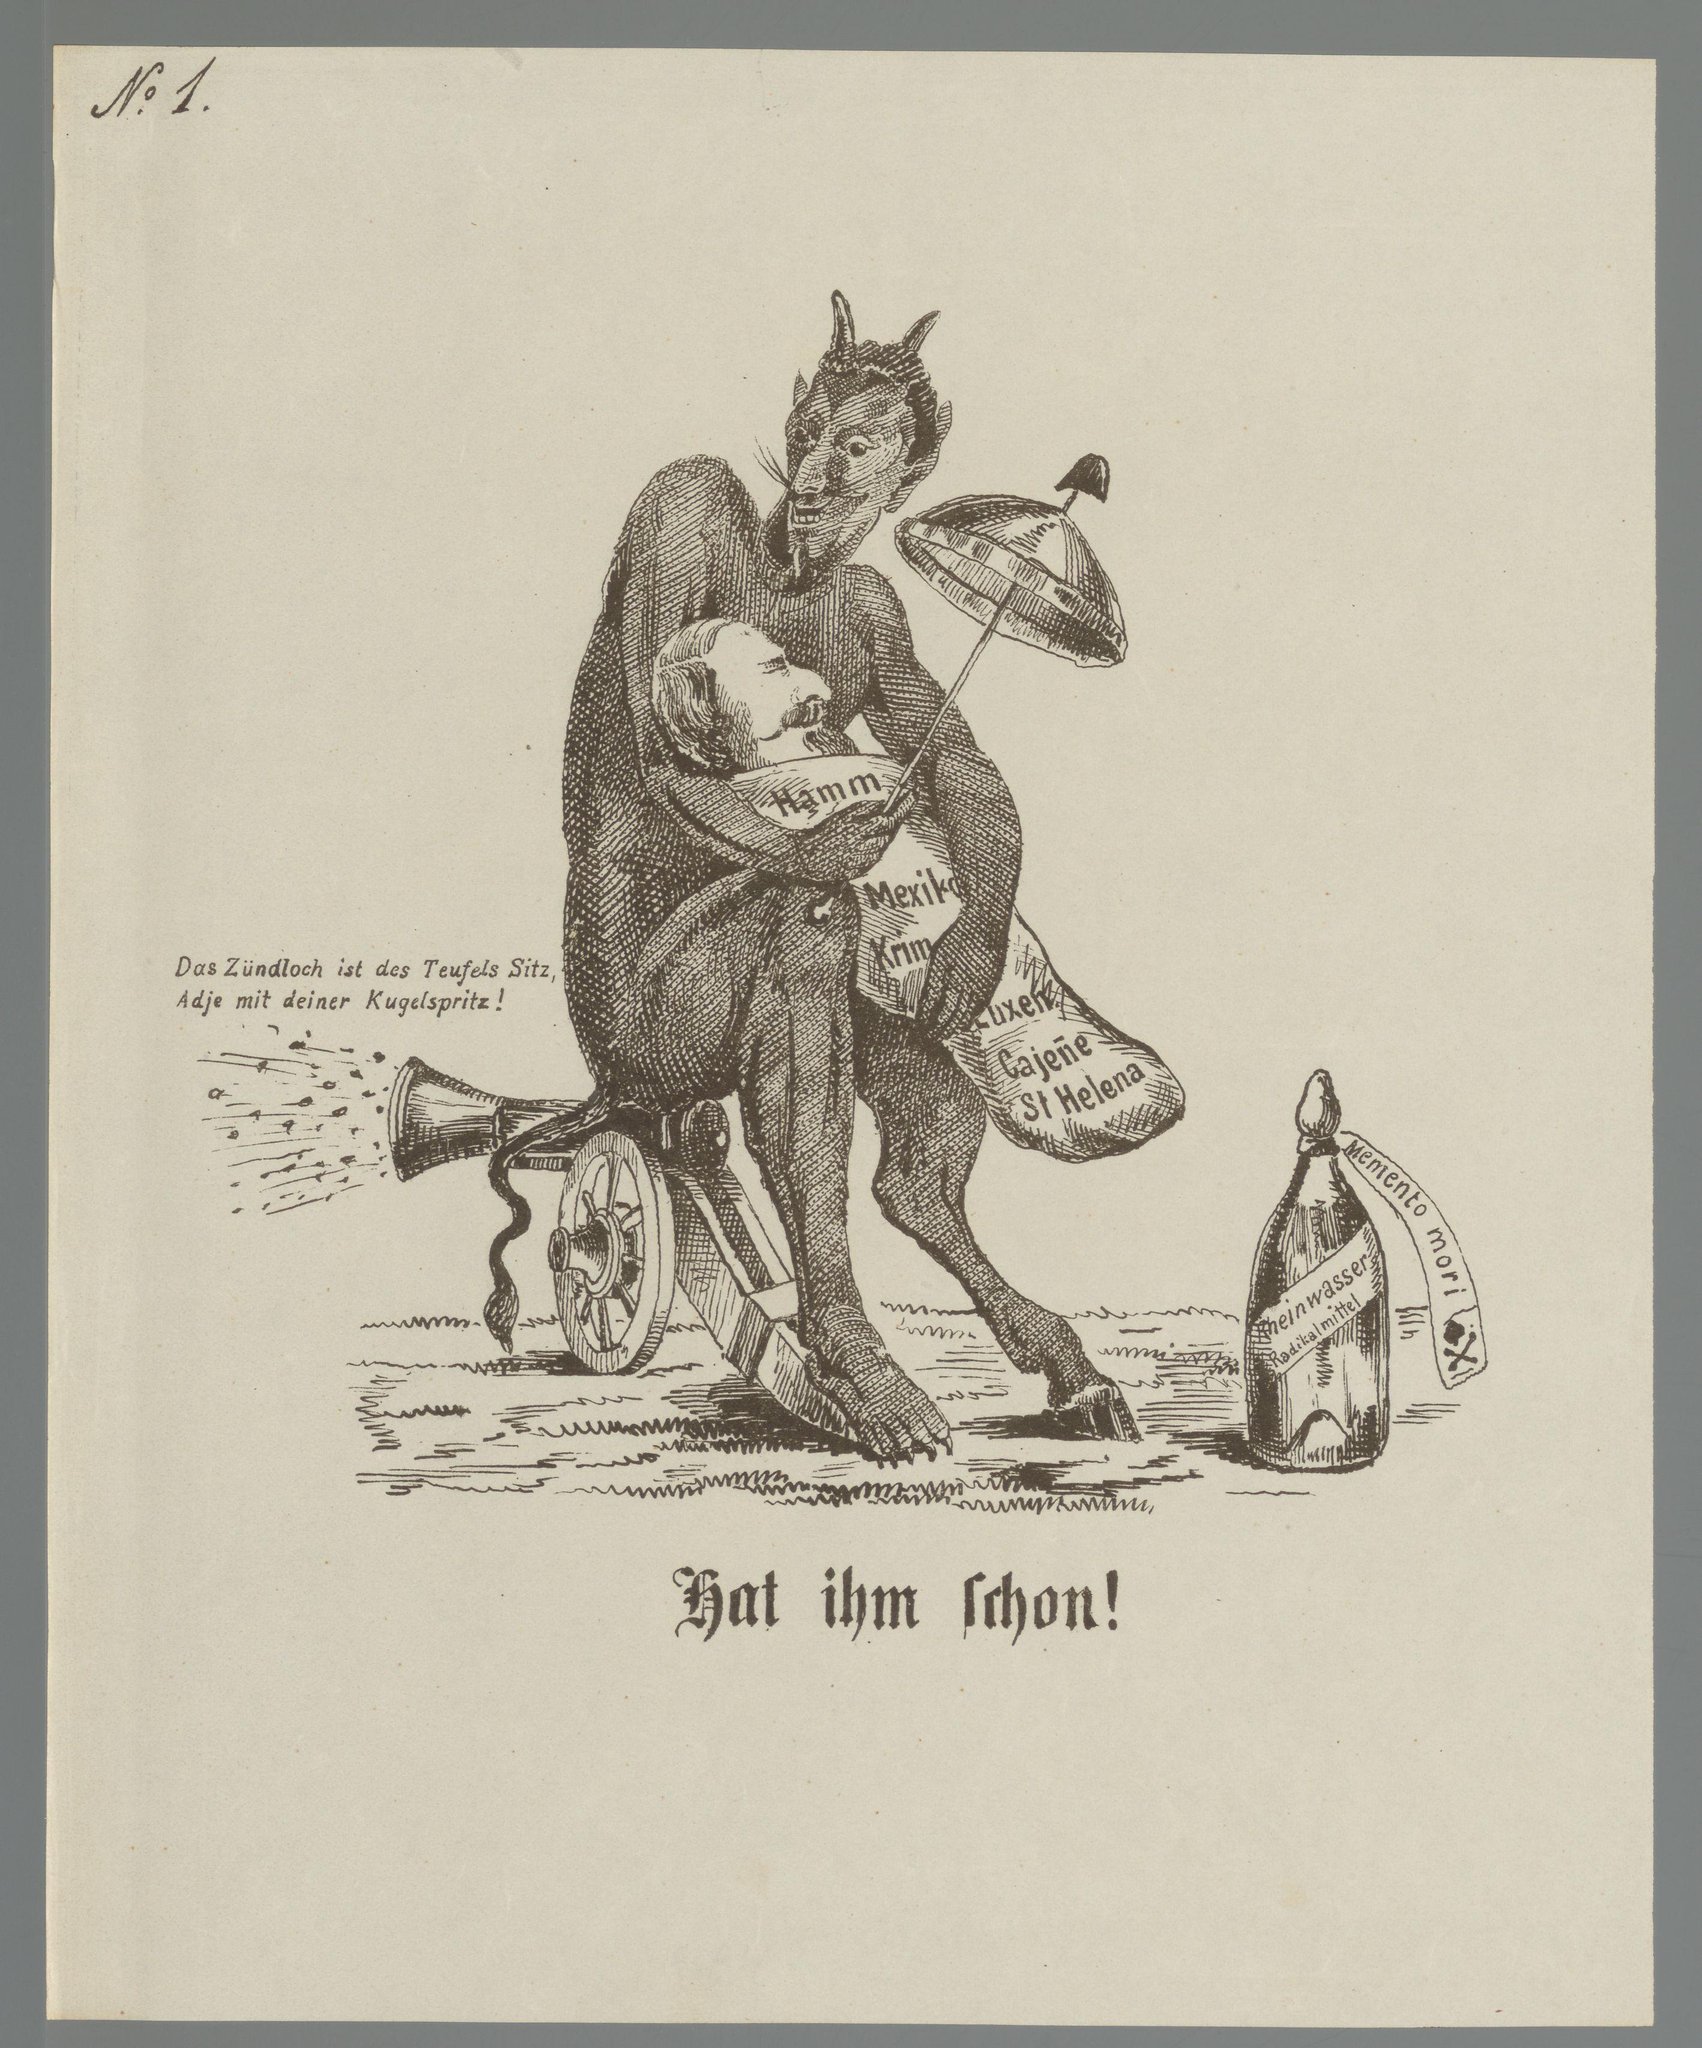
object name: cartoon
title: Hat ihm schon!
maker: Anonymous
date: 1830-1880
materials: paper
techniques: lithograph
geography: germany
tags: adult man, devil(s) and demons, container of glass: bottle, jar, vase, umbrella